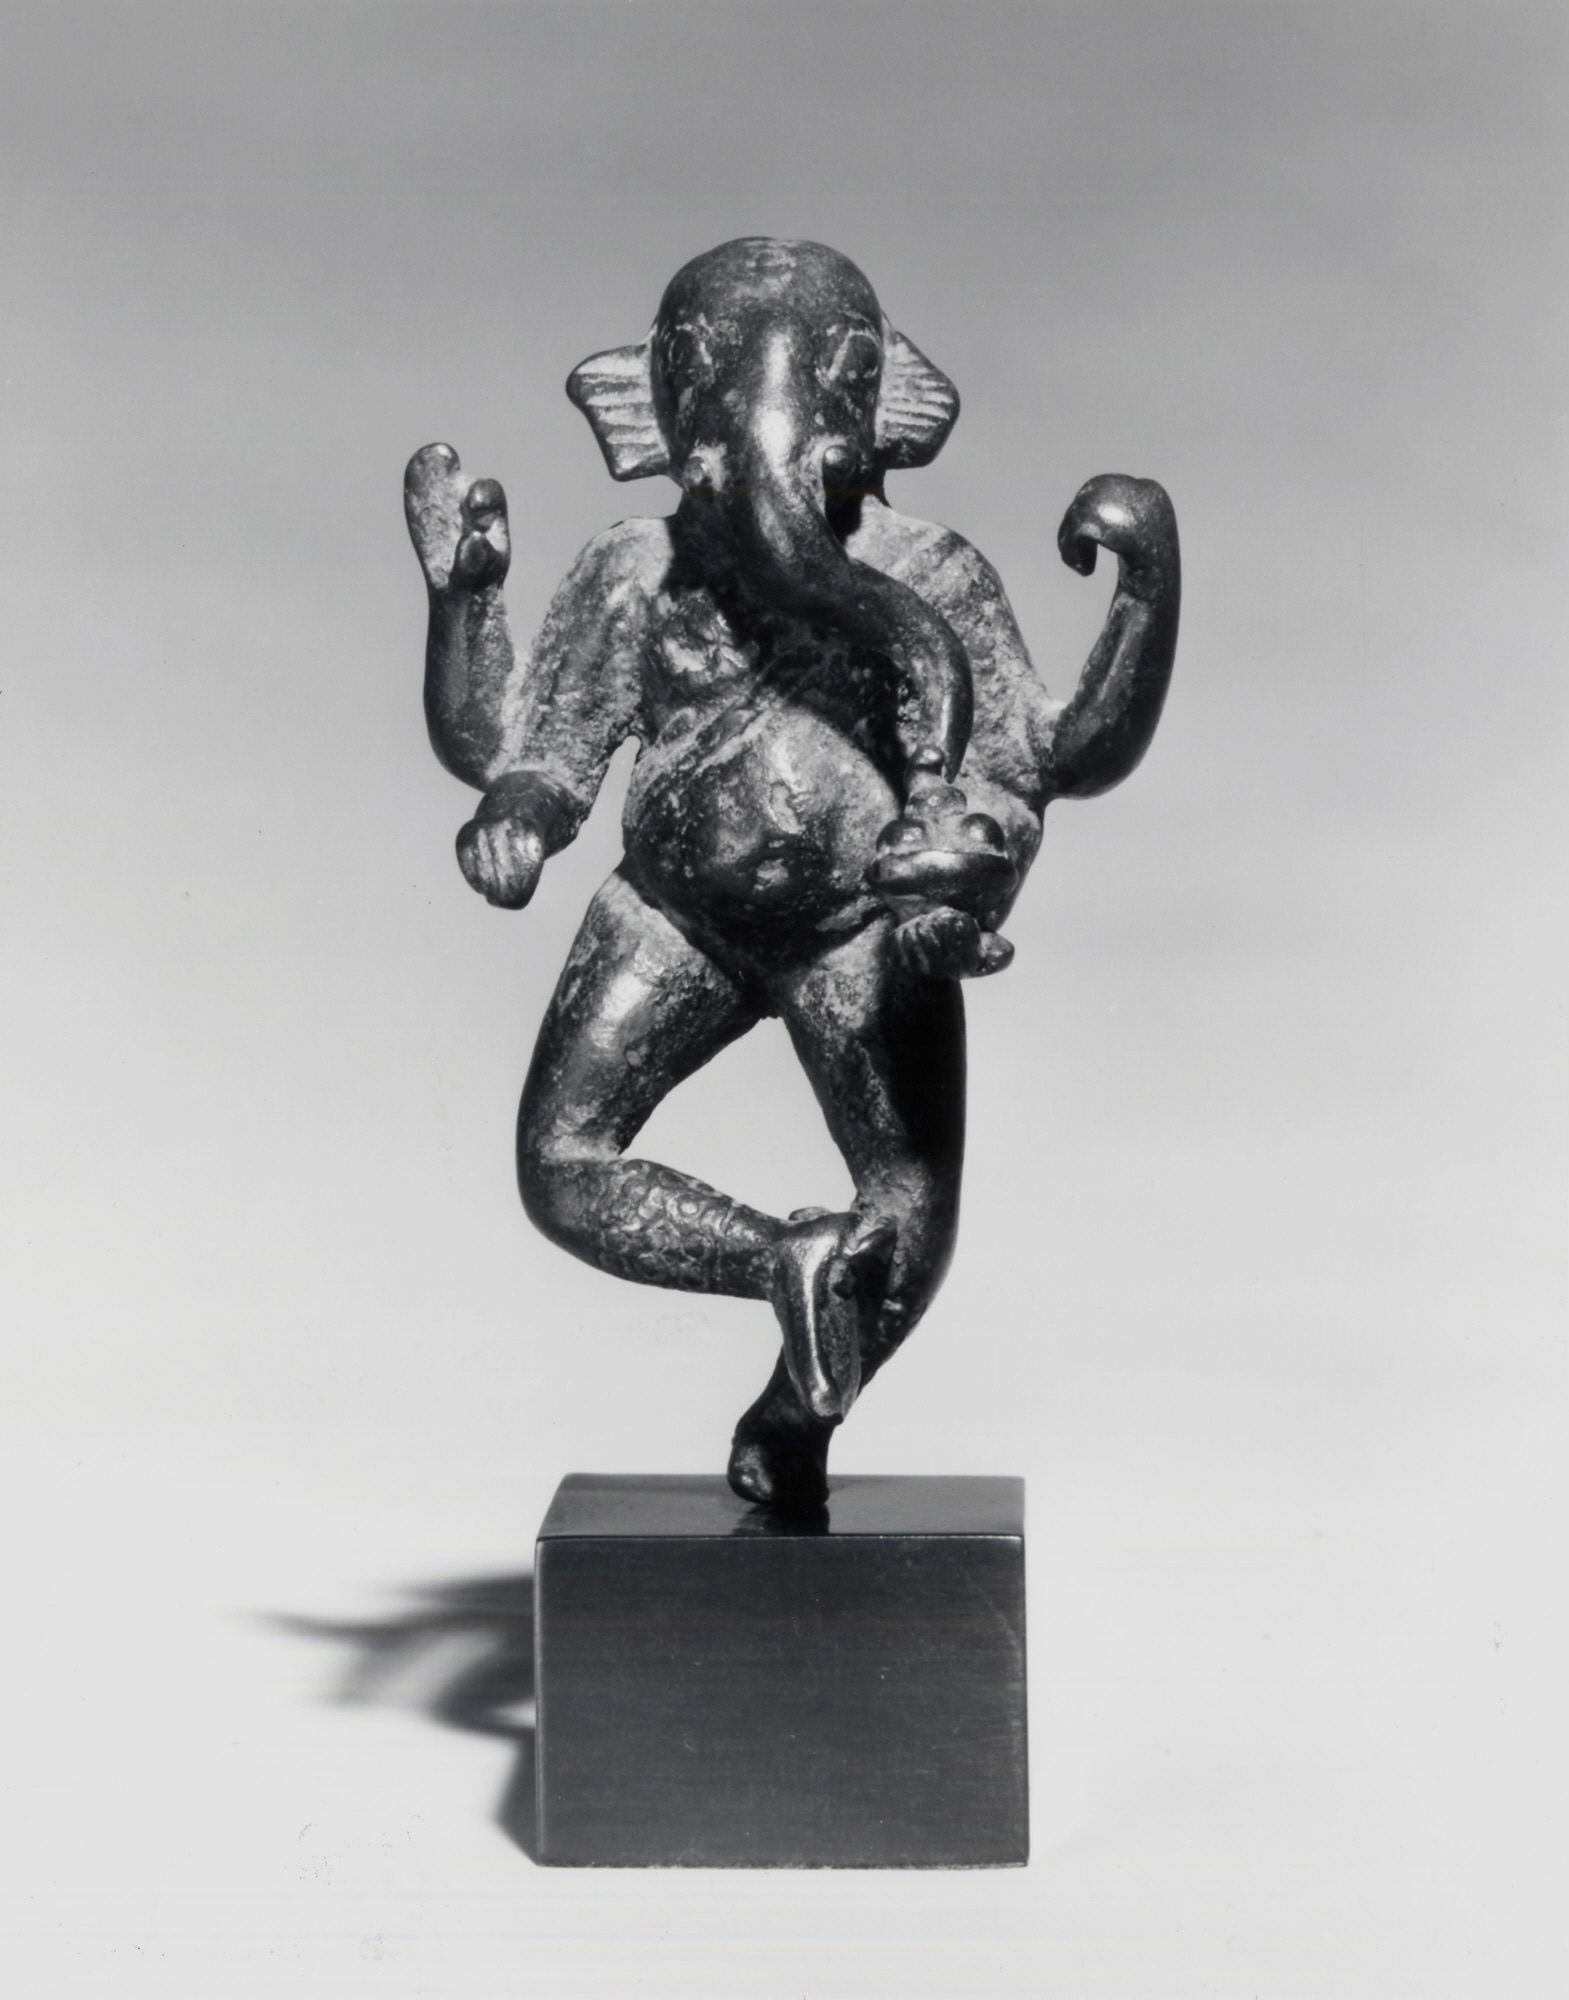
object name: figure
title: Dancing Ganesha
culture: nepali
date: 1201-1300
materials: bronze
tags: dancing,ganesha,hinduism